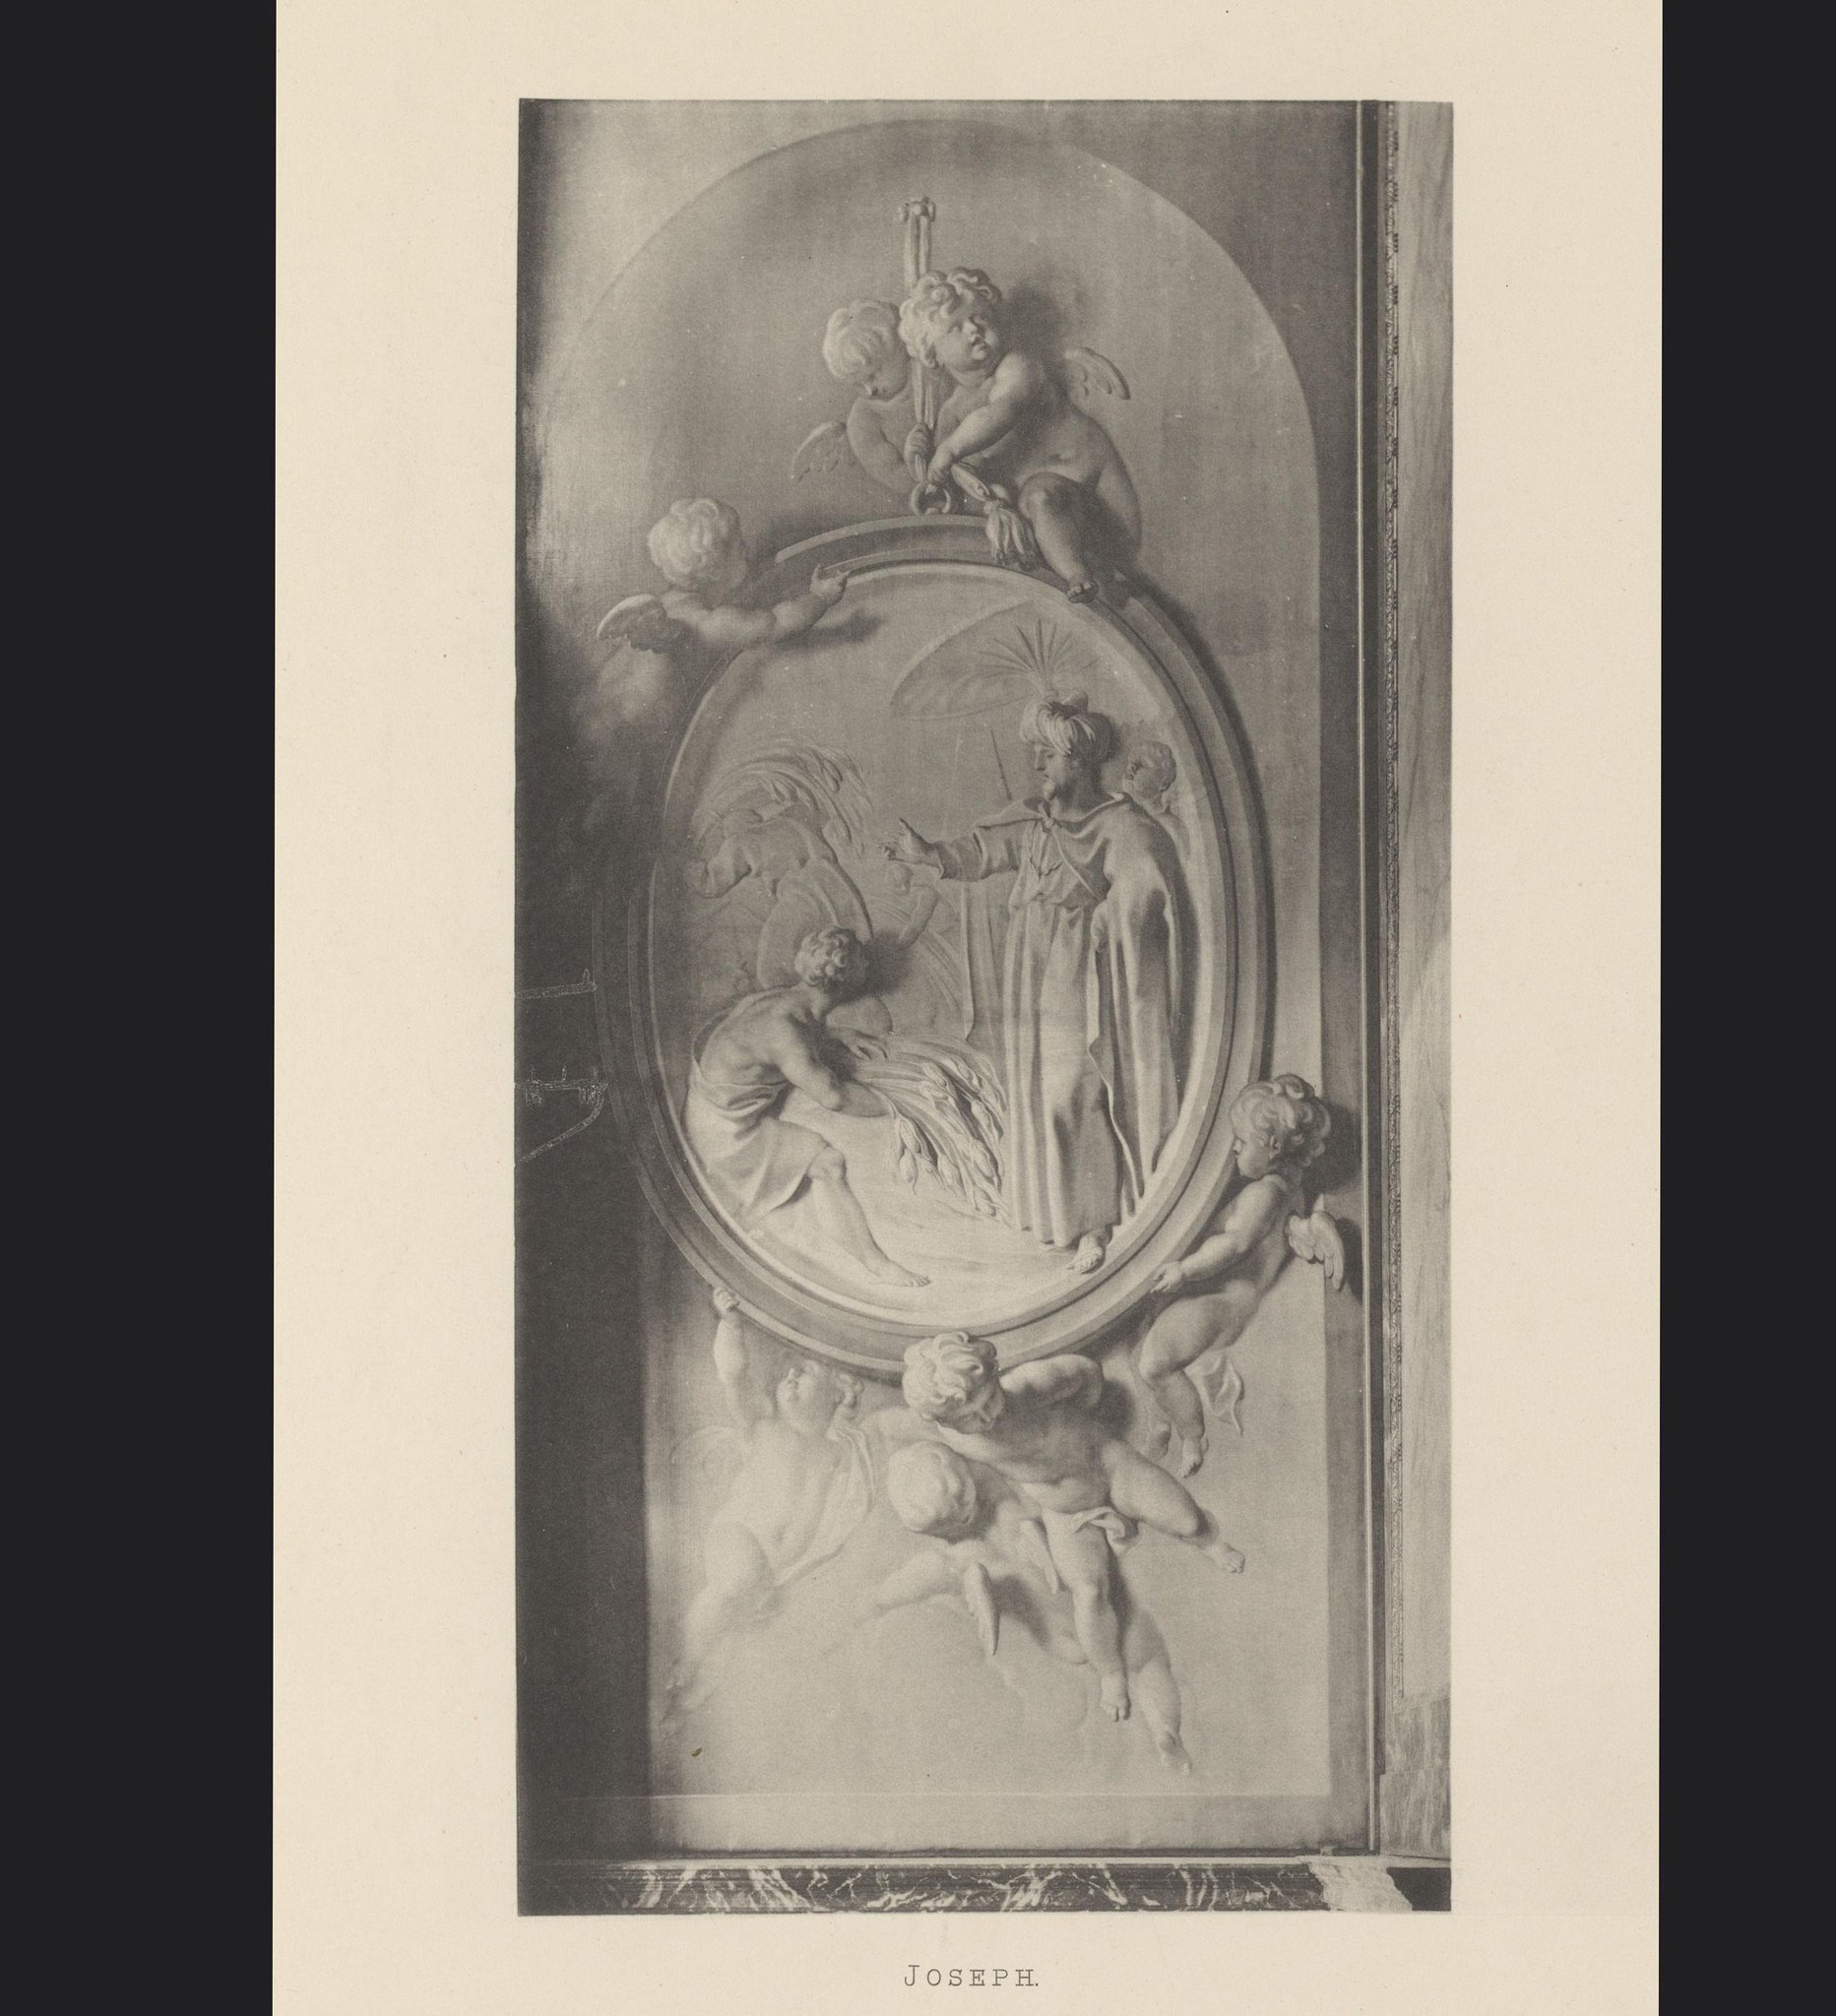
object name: photograph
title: Wandschildering `Joseph' boven de deuren van de Mozeszaal, Paleis op de Dam, Amsterdam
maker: Anonymous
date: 1899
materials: cardboard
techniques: photograph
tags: palace, picture, painting, royal palace of amsterdam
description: Mozeszaal. Wandschilderingen boven de deuren. / Joseph.